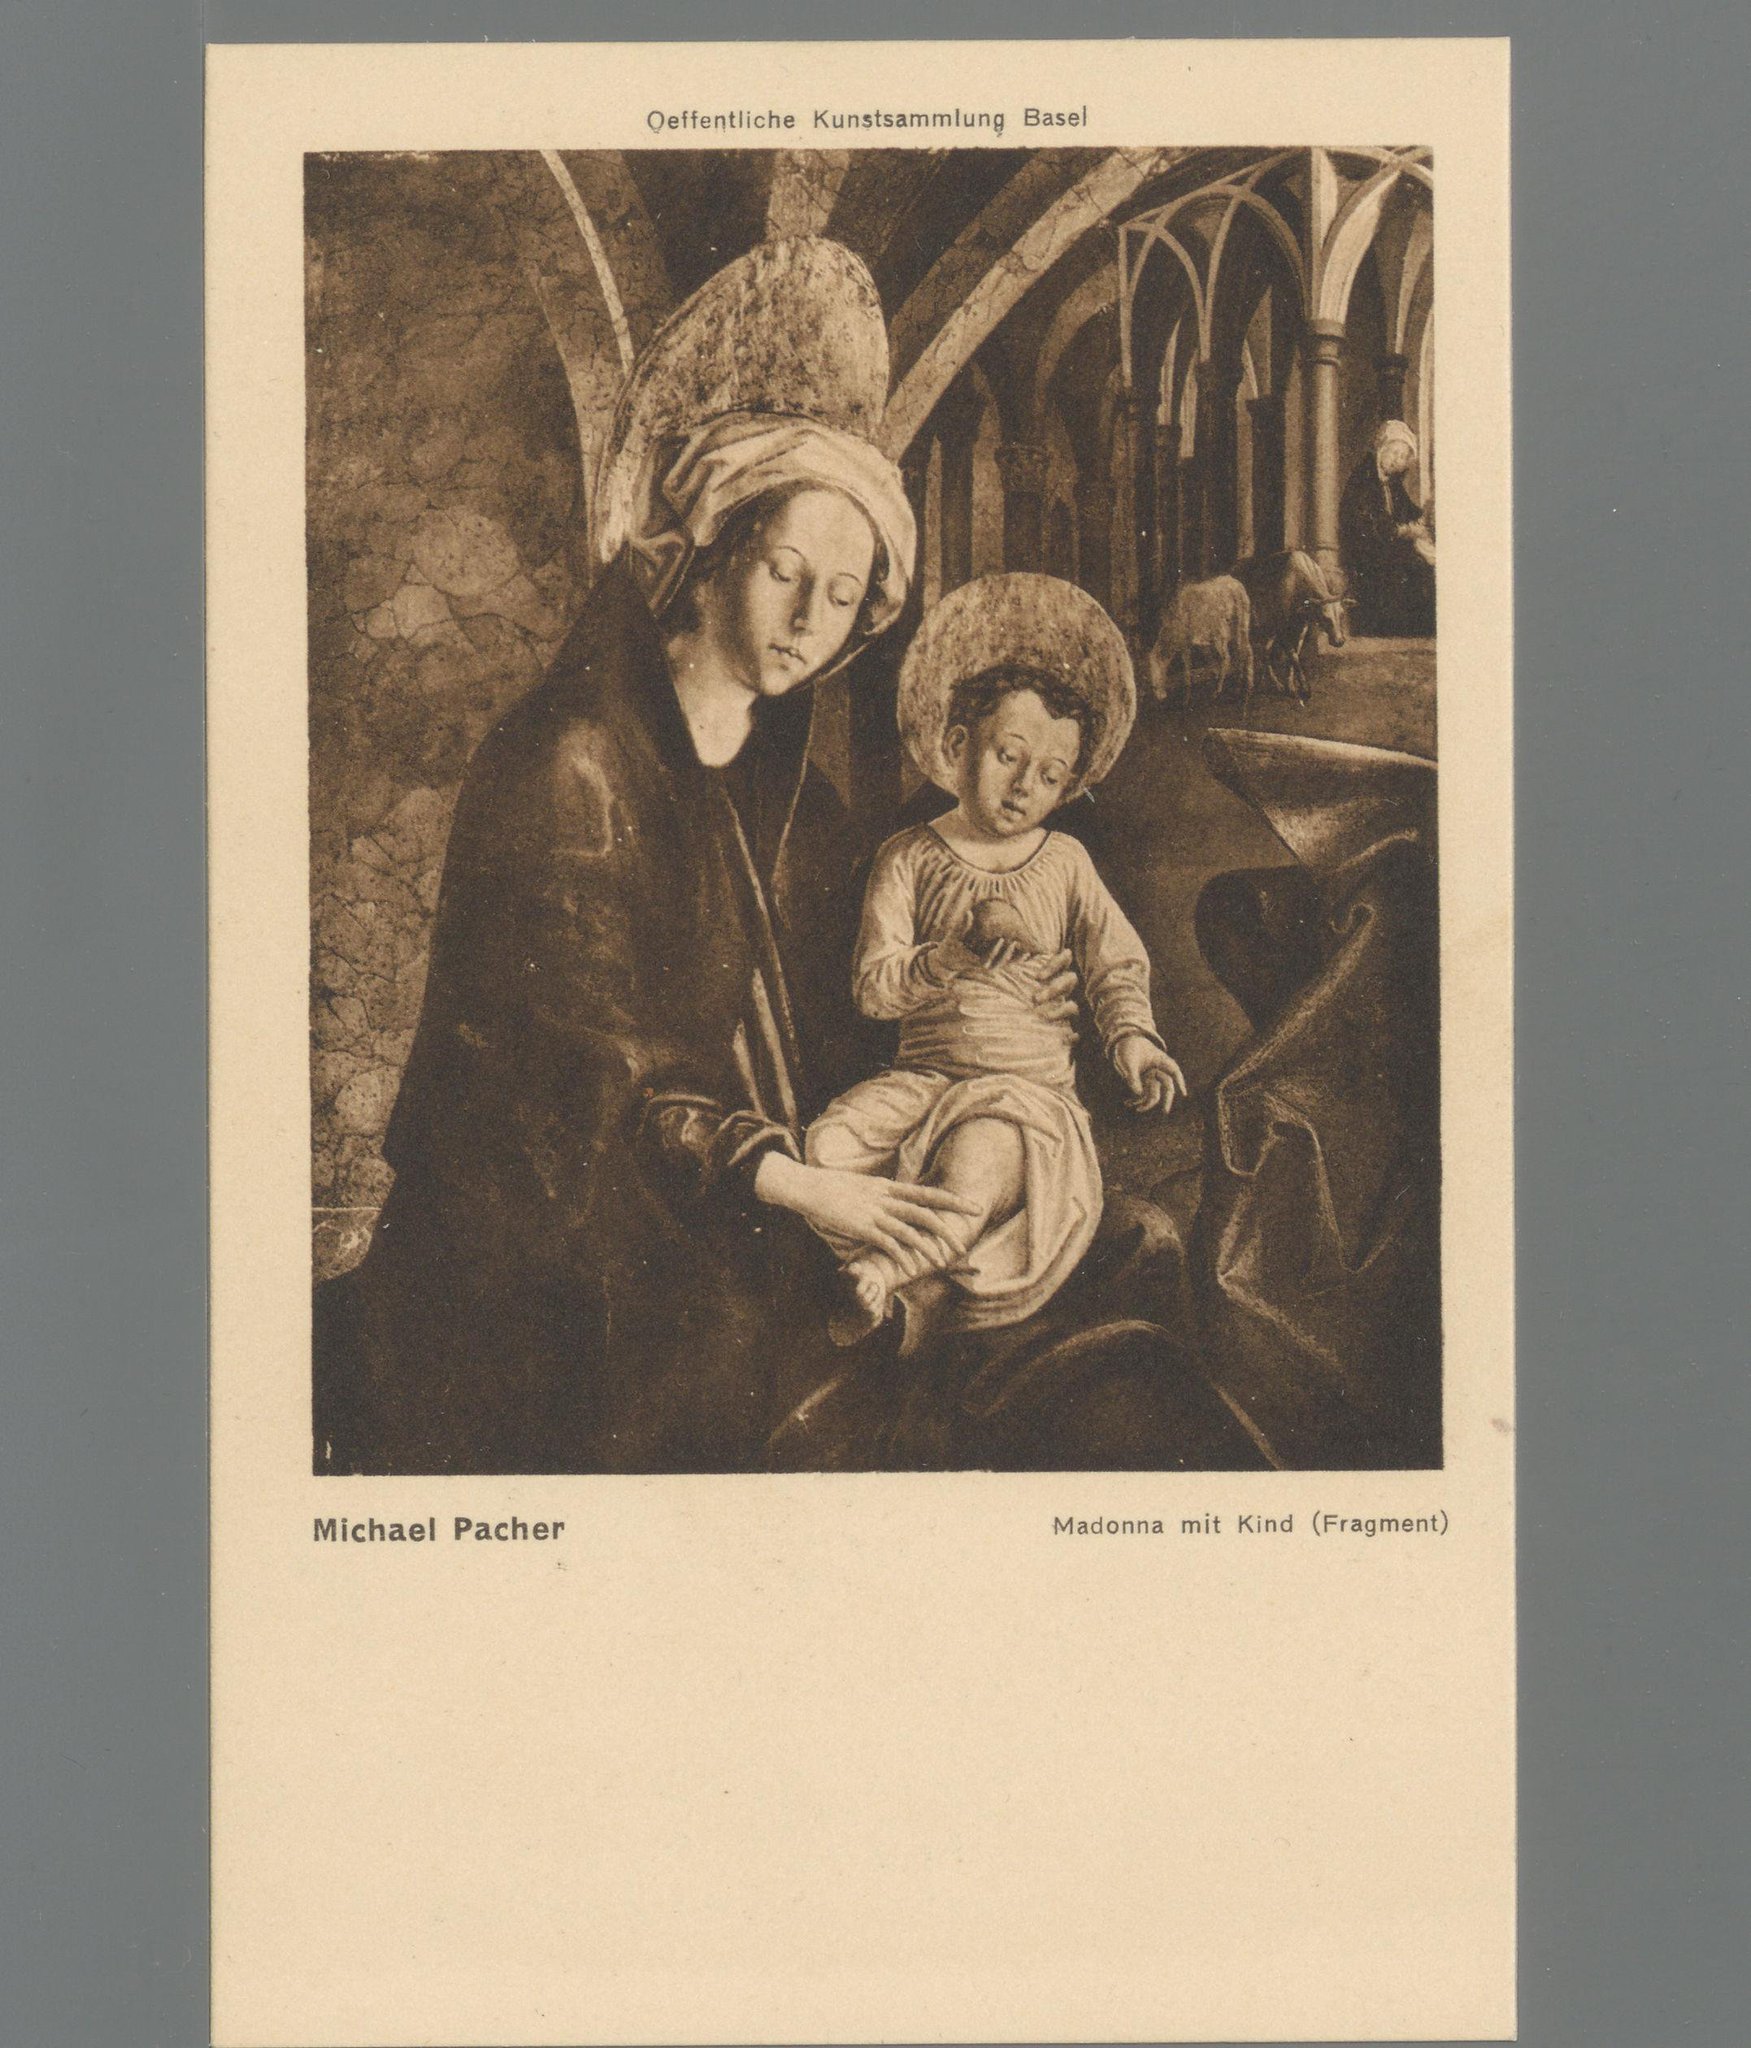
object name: ansichtkaart, prentbriefkaart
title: Oeffentliche Kunstsammlung Basel. Michael Pacher. Madonna mit Kind (fragment)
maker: michael pacher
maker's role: painter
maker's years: 1435-1498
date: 1905-1930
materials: cardboard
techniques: photograph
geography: basel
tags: permanent exhibition, museum, picture, painting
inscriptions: collector's mark: ‘AFE v S’